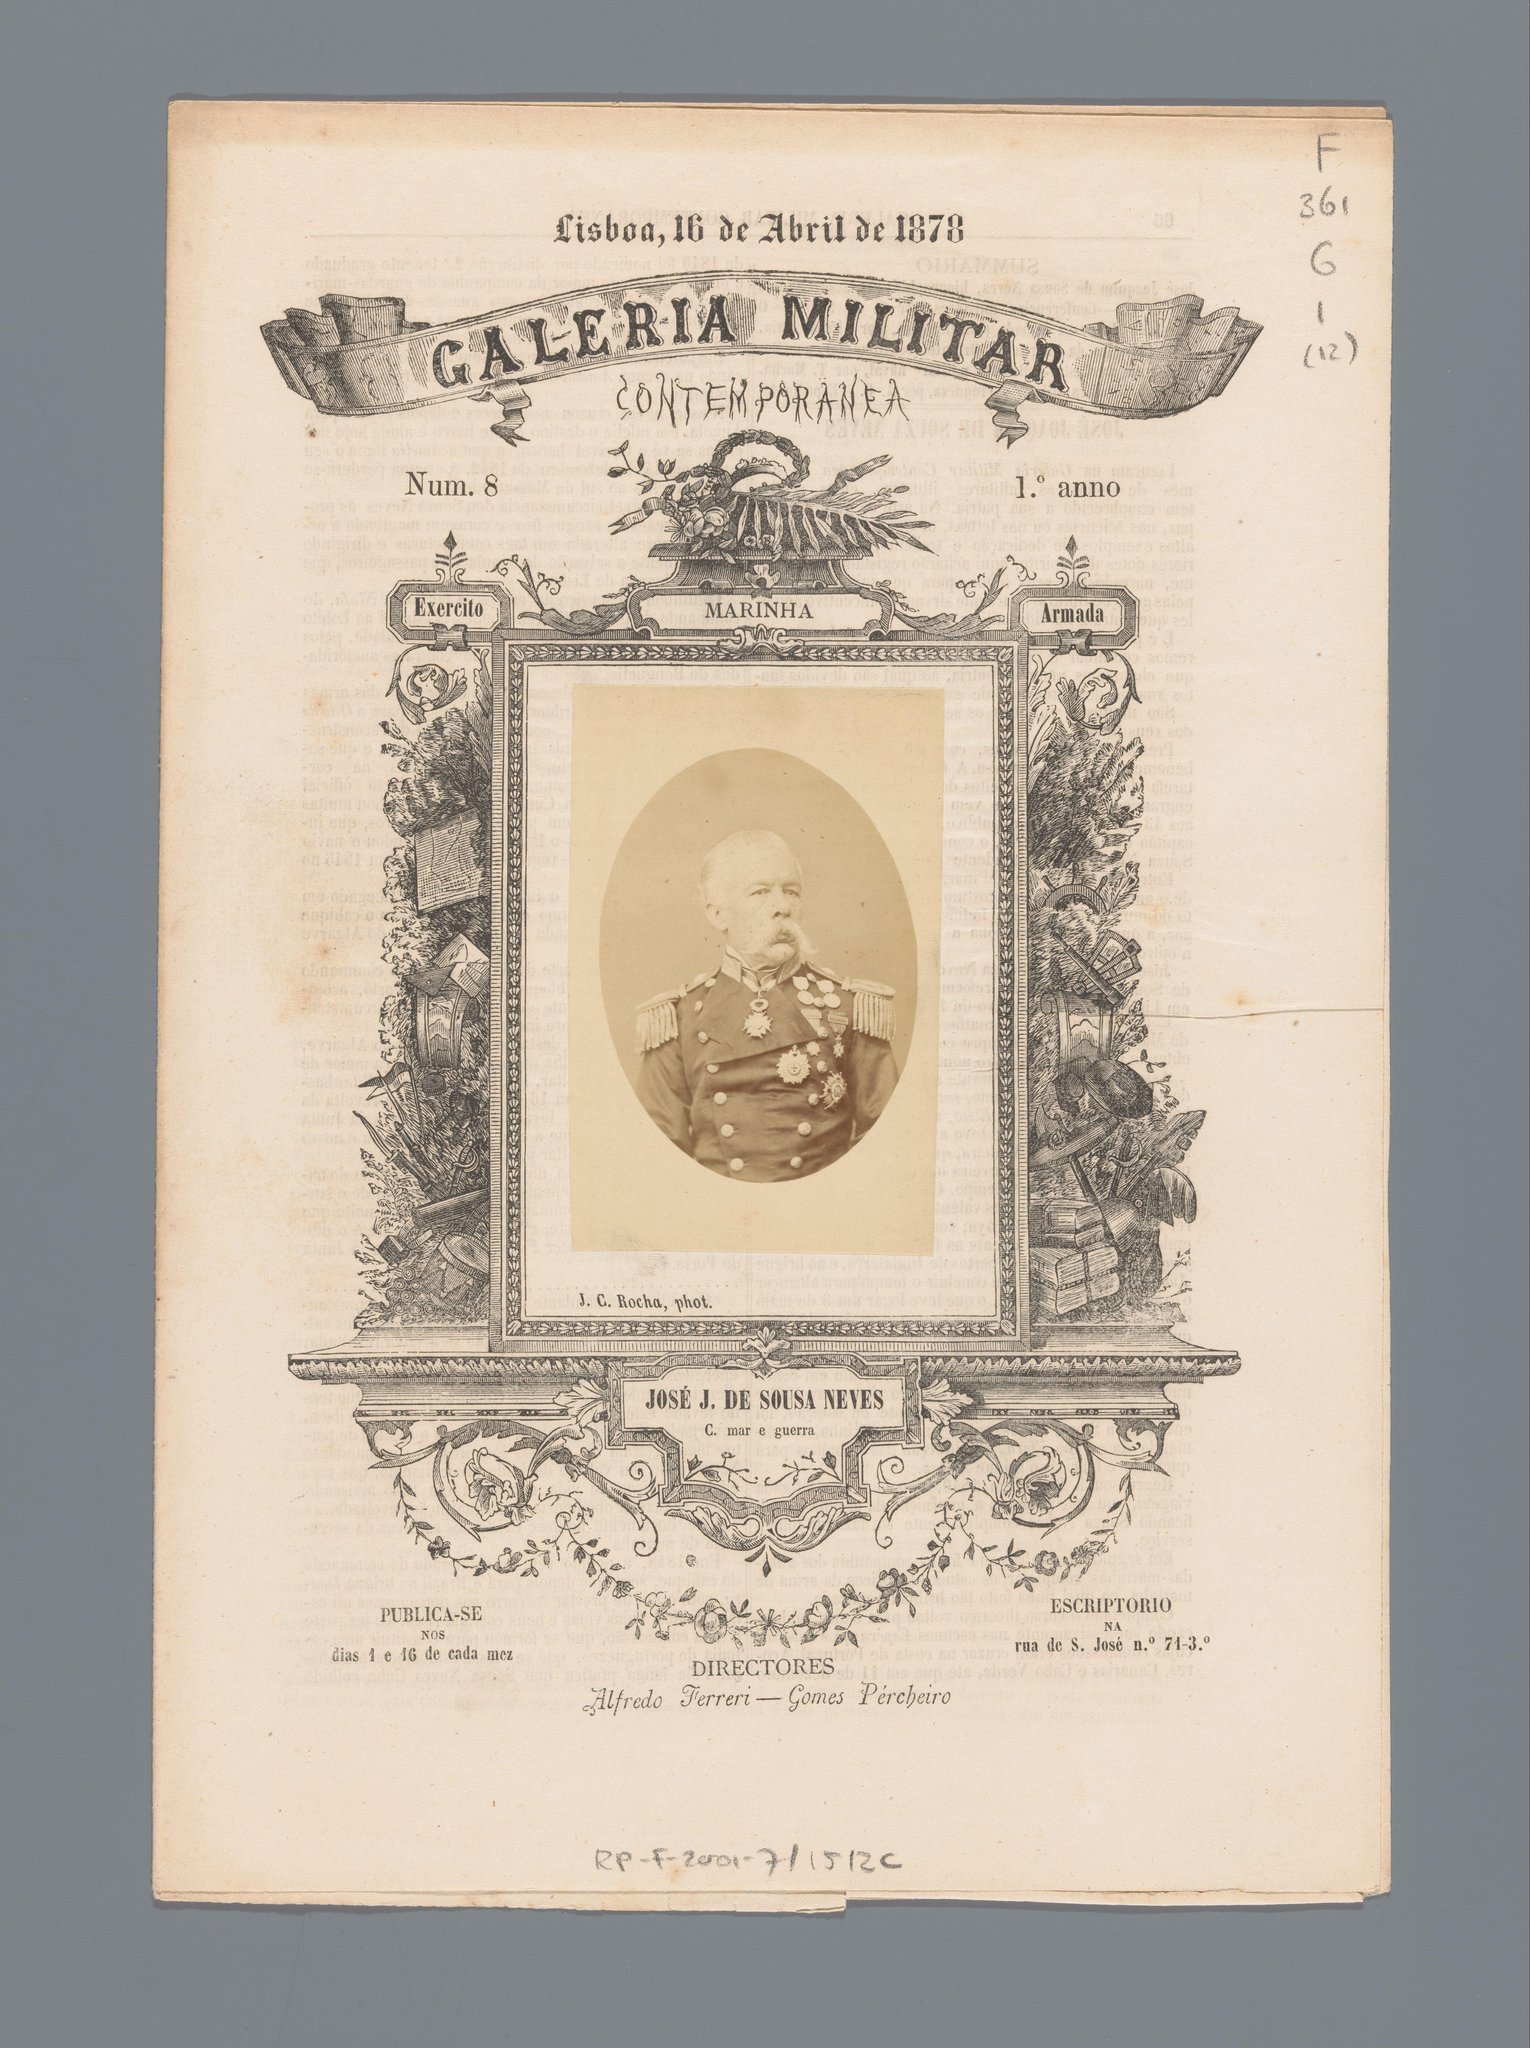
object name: book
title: Galeria militar contemporanea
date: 1878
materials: paper, photographic support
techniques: albumen print, printing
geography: lisbon